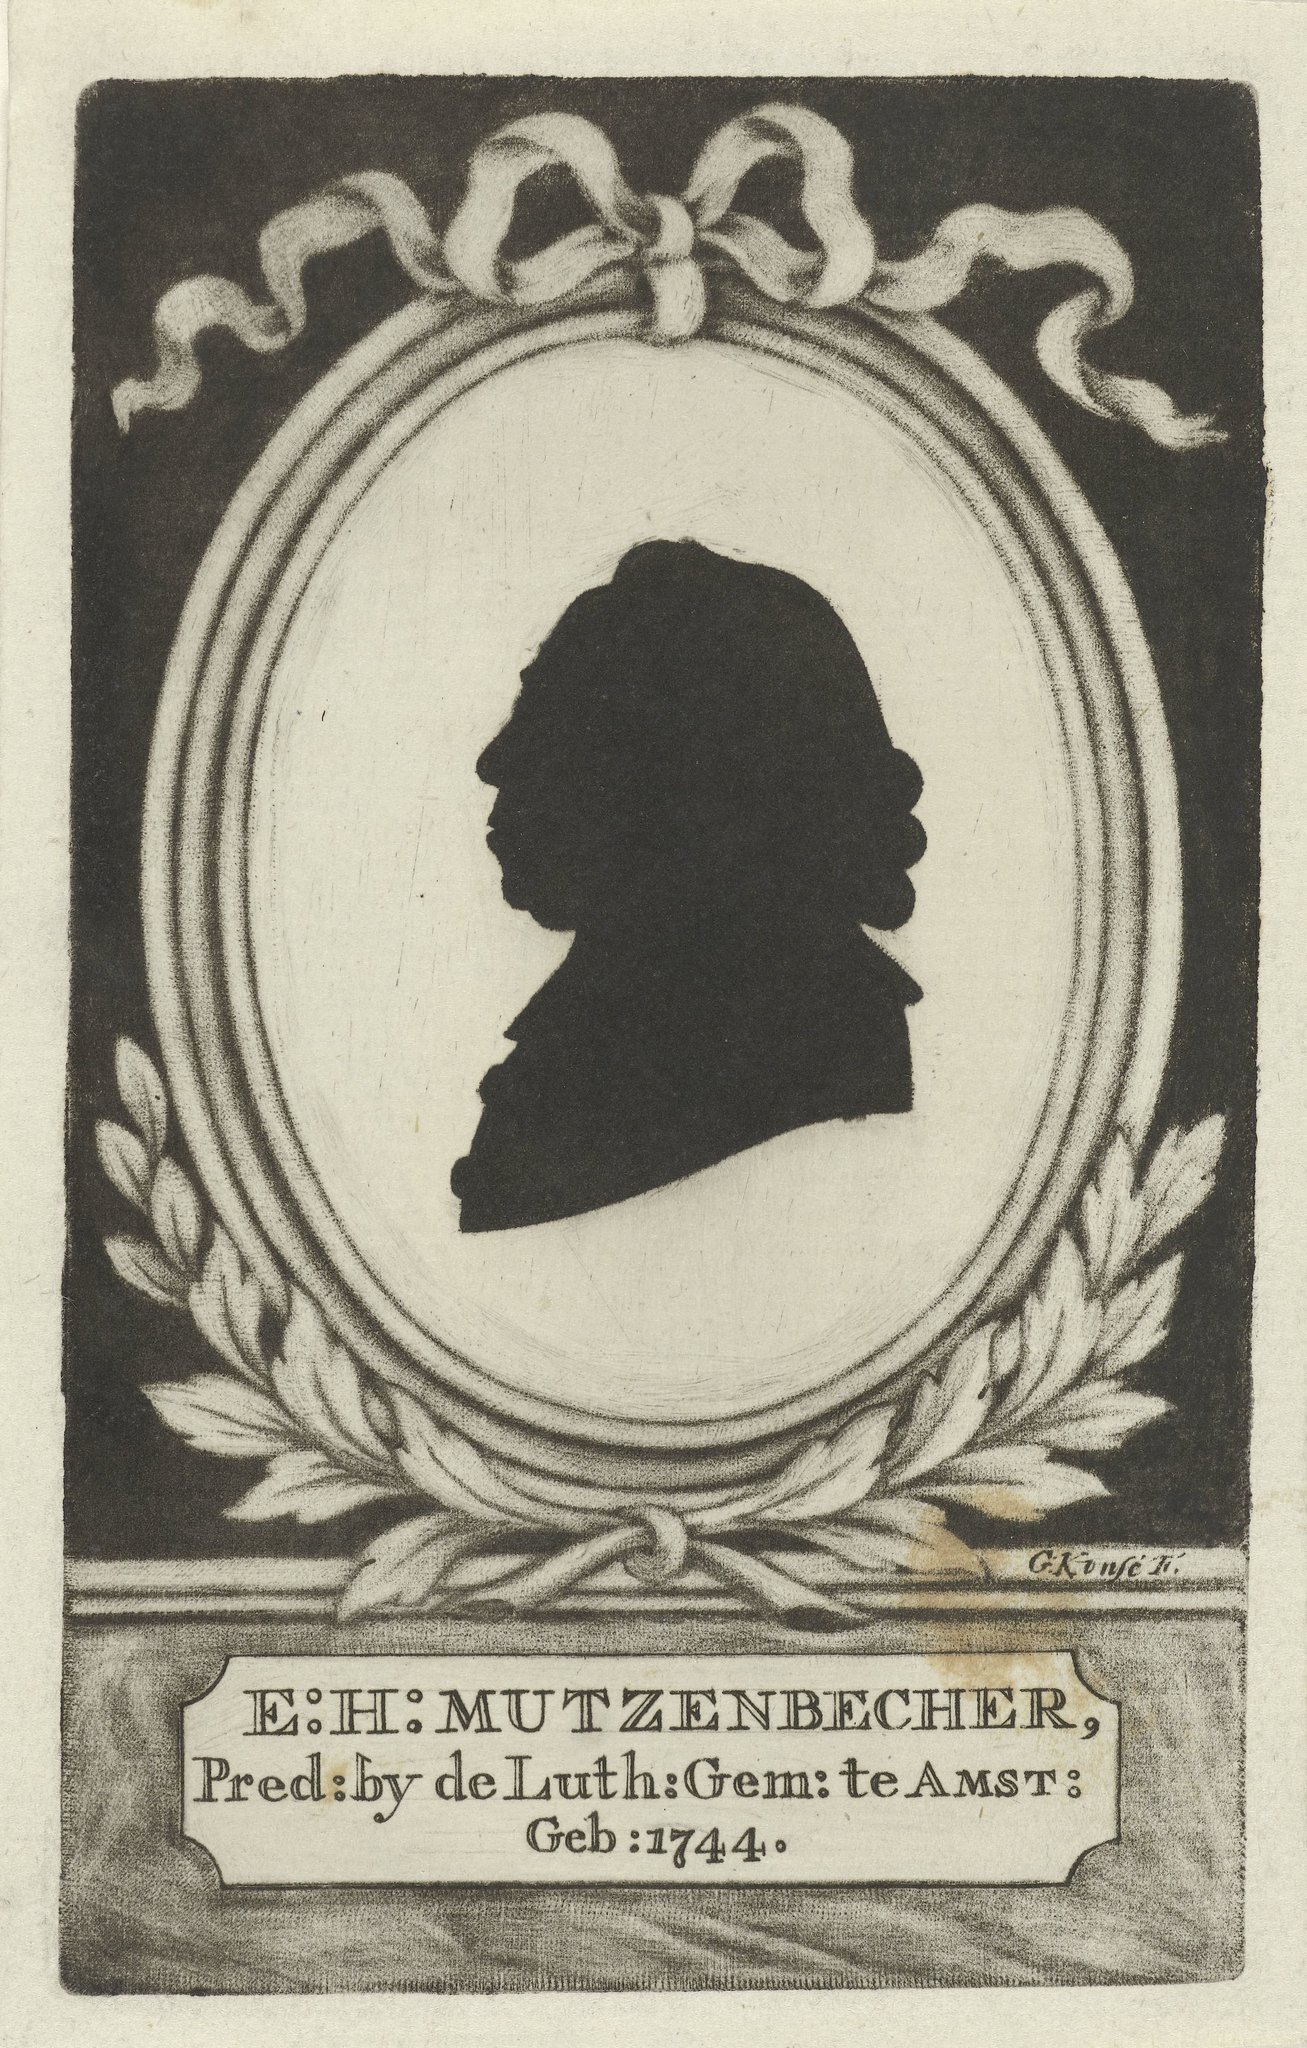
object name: print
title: Silhouetportret van Esdras Heinrich Mützenbecher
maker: gerrit konsé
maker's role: print maker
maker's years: 1751-1826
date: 1744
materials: paper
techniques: mezzotint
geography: amsterdam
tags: esdras heinrich mützenbecher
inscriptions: collector's mark: Lugt 2228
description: Portretbuste in profiel naar links van de predikant Esdras Heinrich Mützenbecher, in een ovale omlijsting met bovenaan een strik. Onder de afbeelding een drieregelig onderschrift.